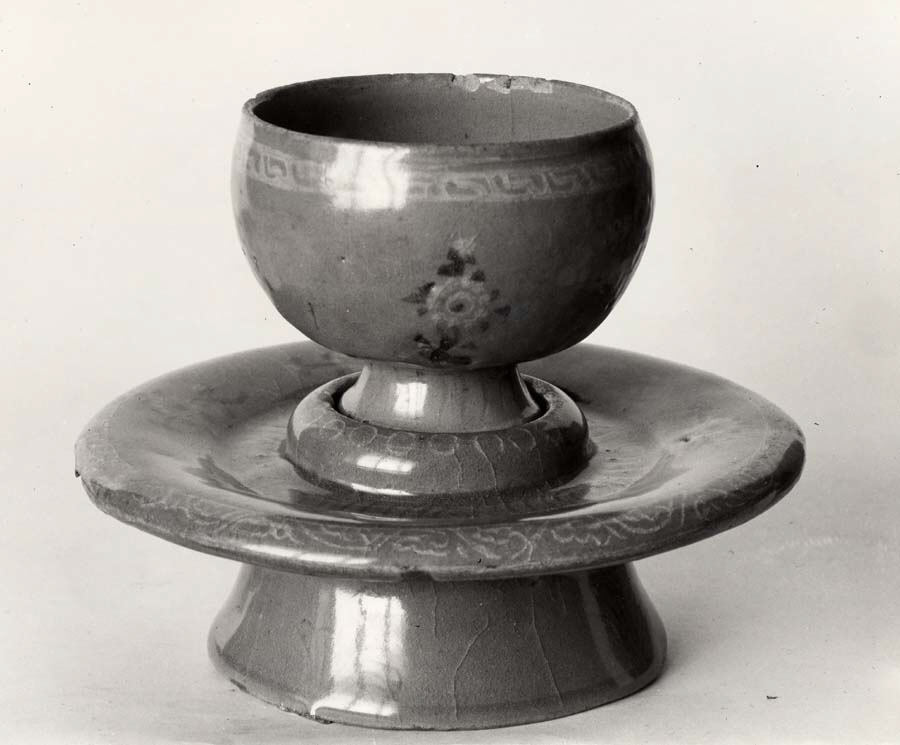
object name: cup stand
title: Cup and Stand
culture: korean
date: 1150-1200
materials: clay